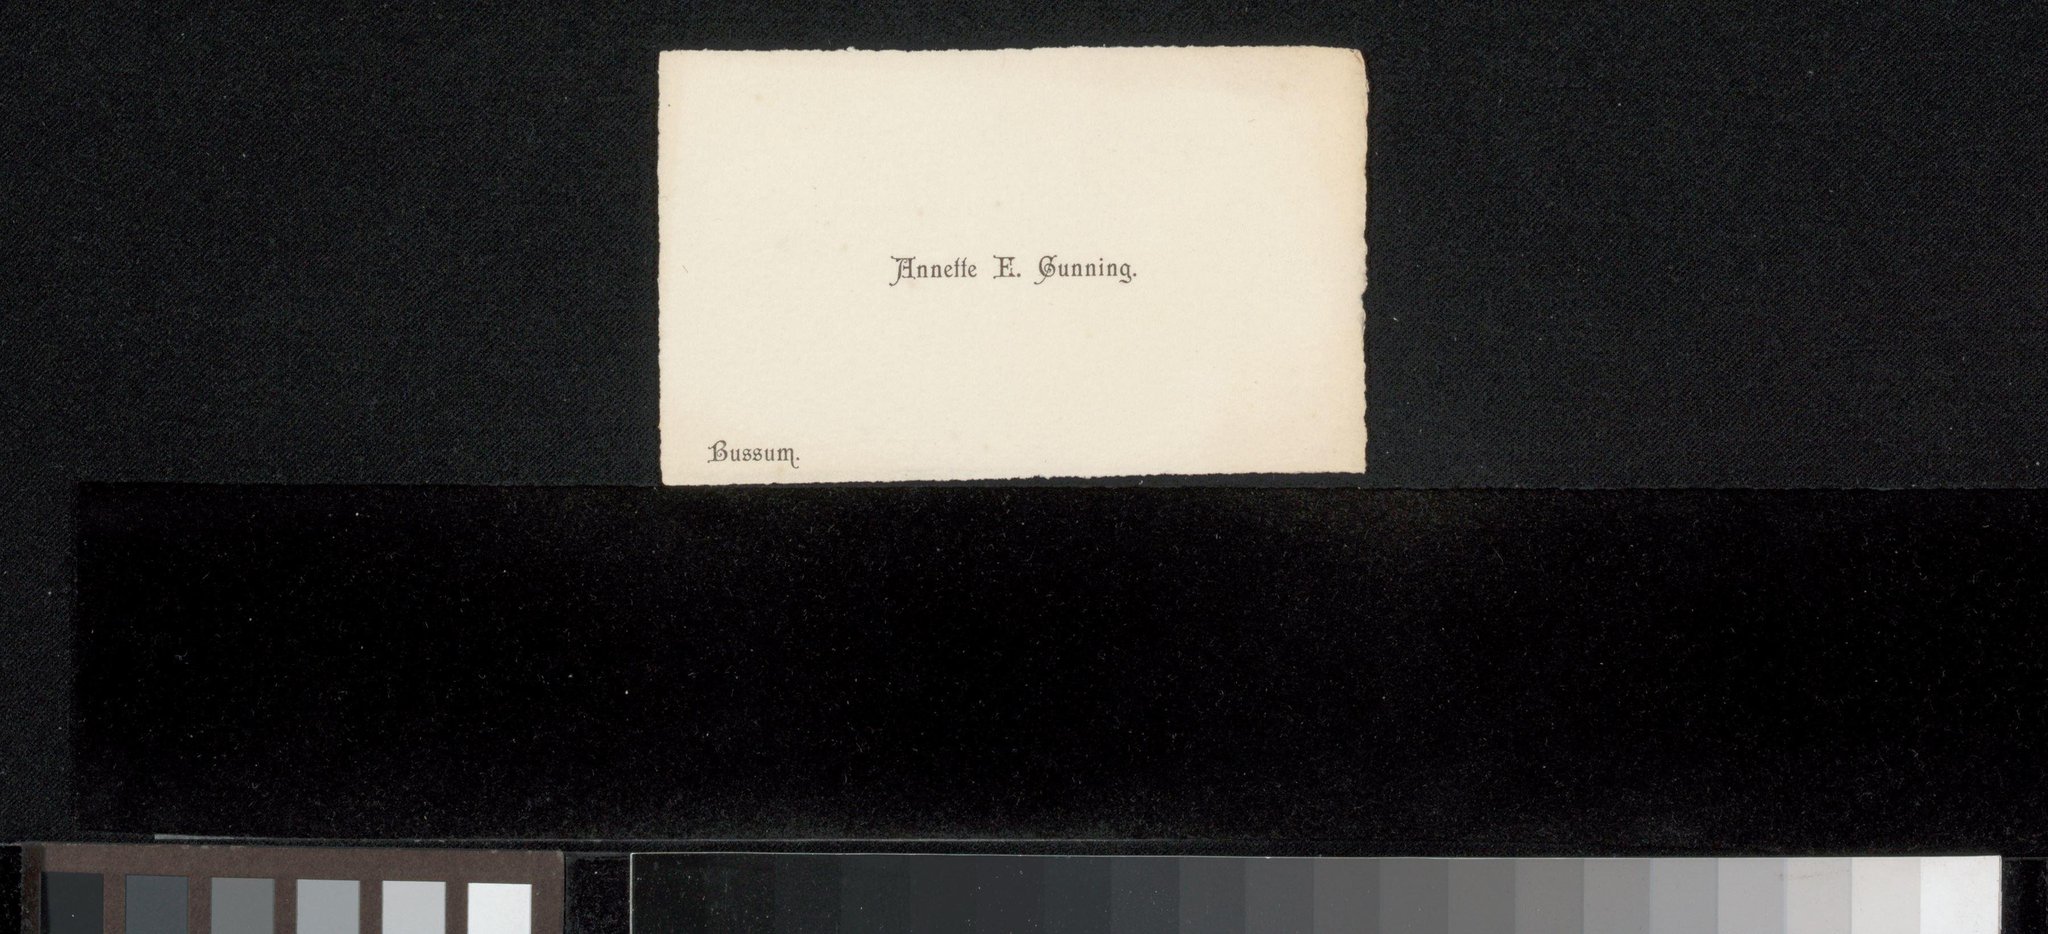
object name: visiting card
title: Visitekaartje aan Philip Zilcken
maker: annette f. gunning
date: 1867-1930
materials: cardboard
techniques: printing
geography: bussum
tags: painter, draughtsman, philip zilcken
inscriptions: collector's mark: ‘RPK’